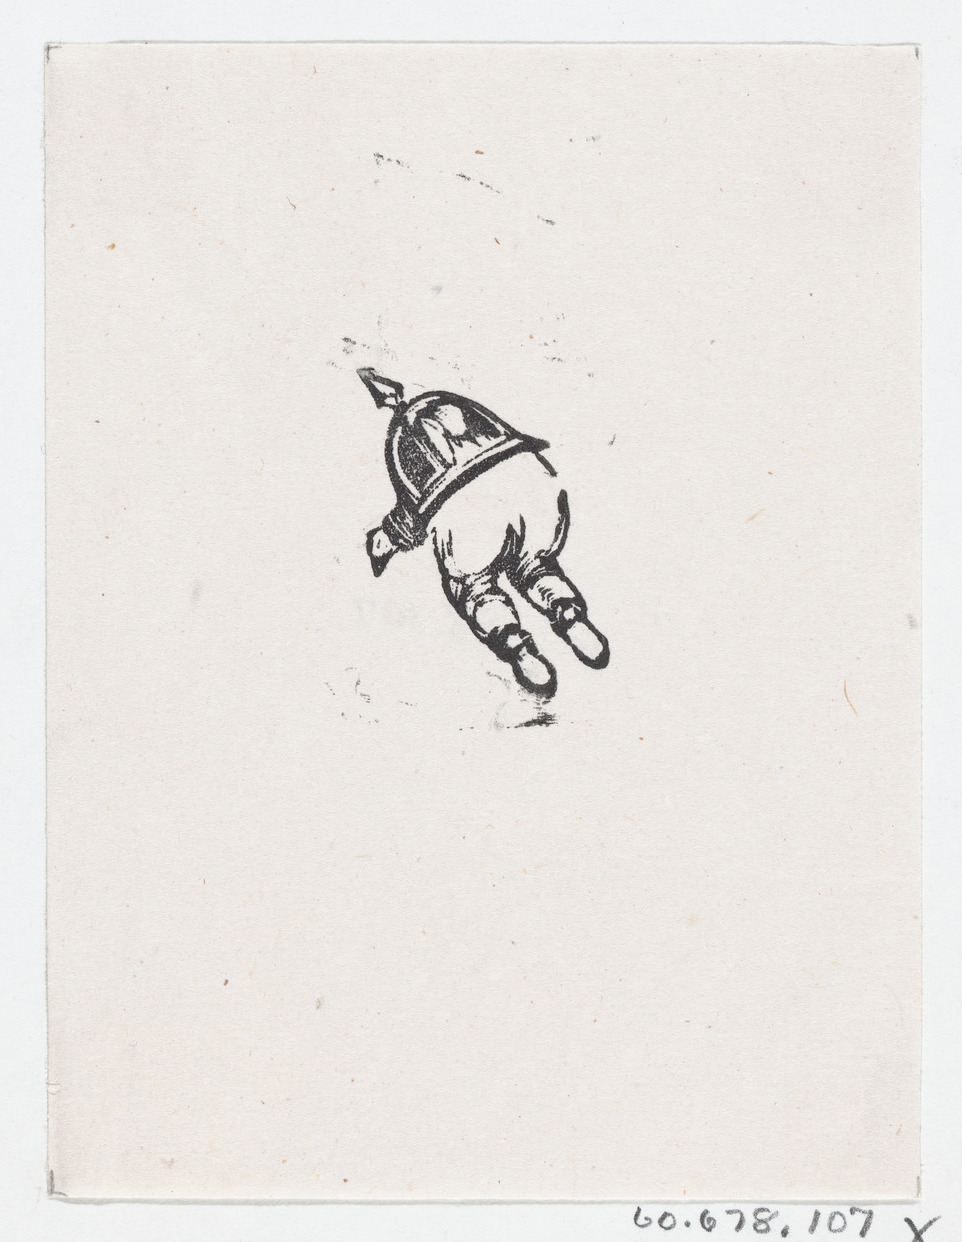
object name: print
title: A helmet and a figure's lower body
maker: josé guadalupe posada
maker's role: artist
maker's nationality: mexican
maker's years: 1852-1913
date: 1880-1910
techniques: lithography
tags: helmets